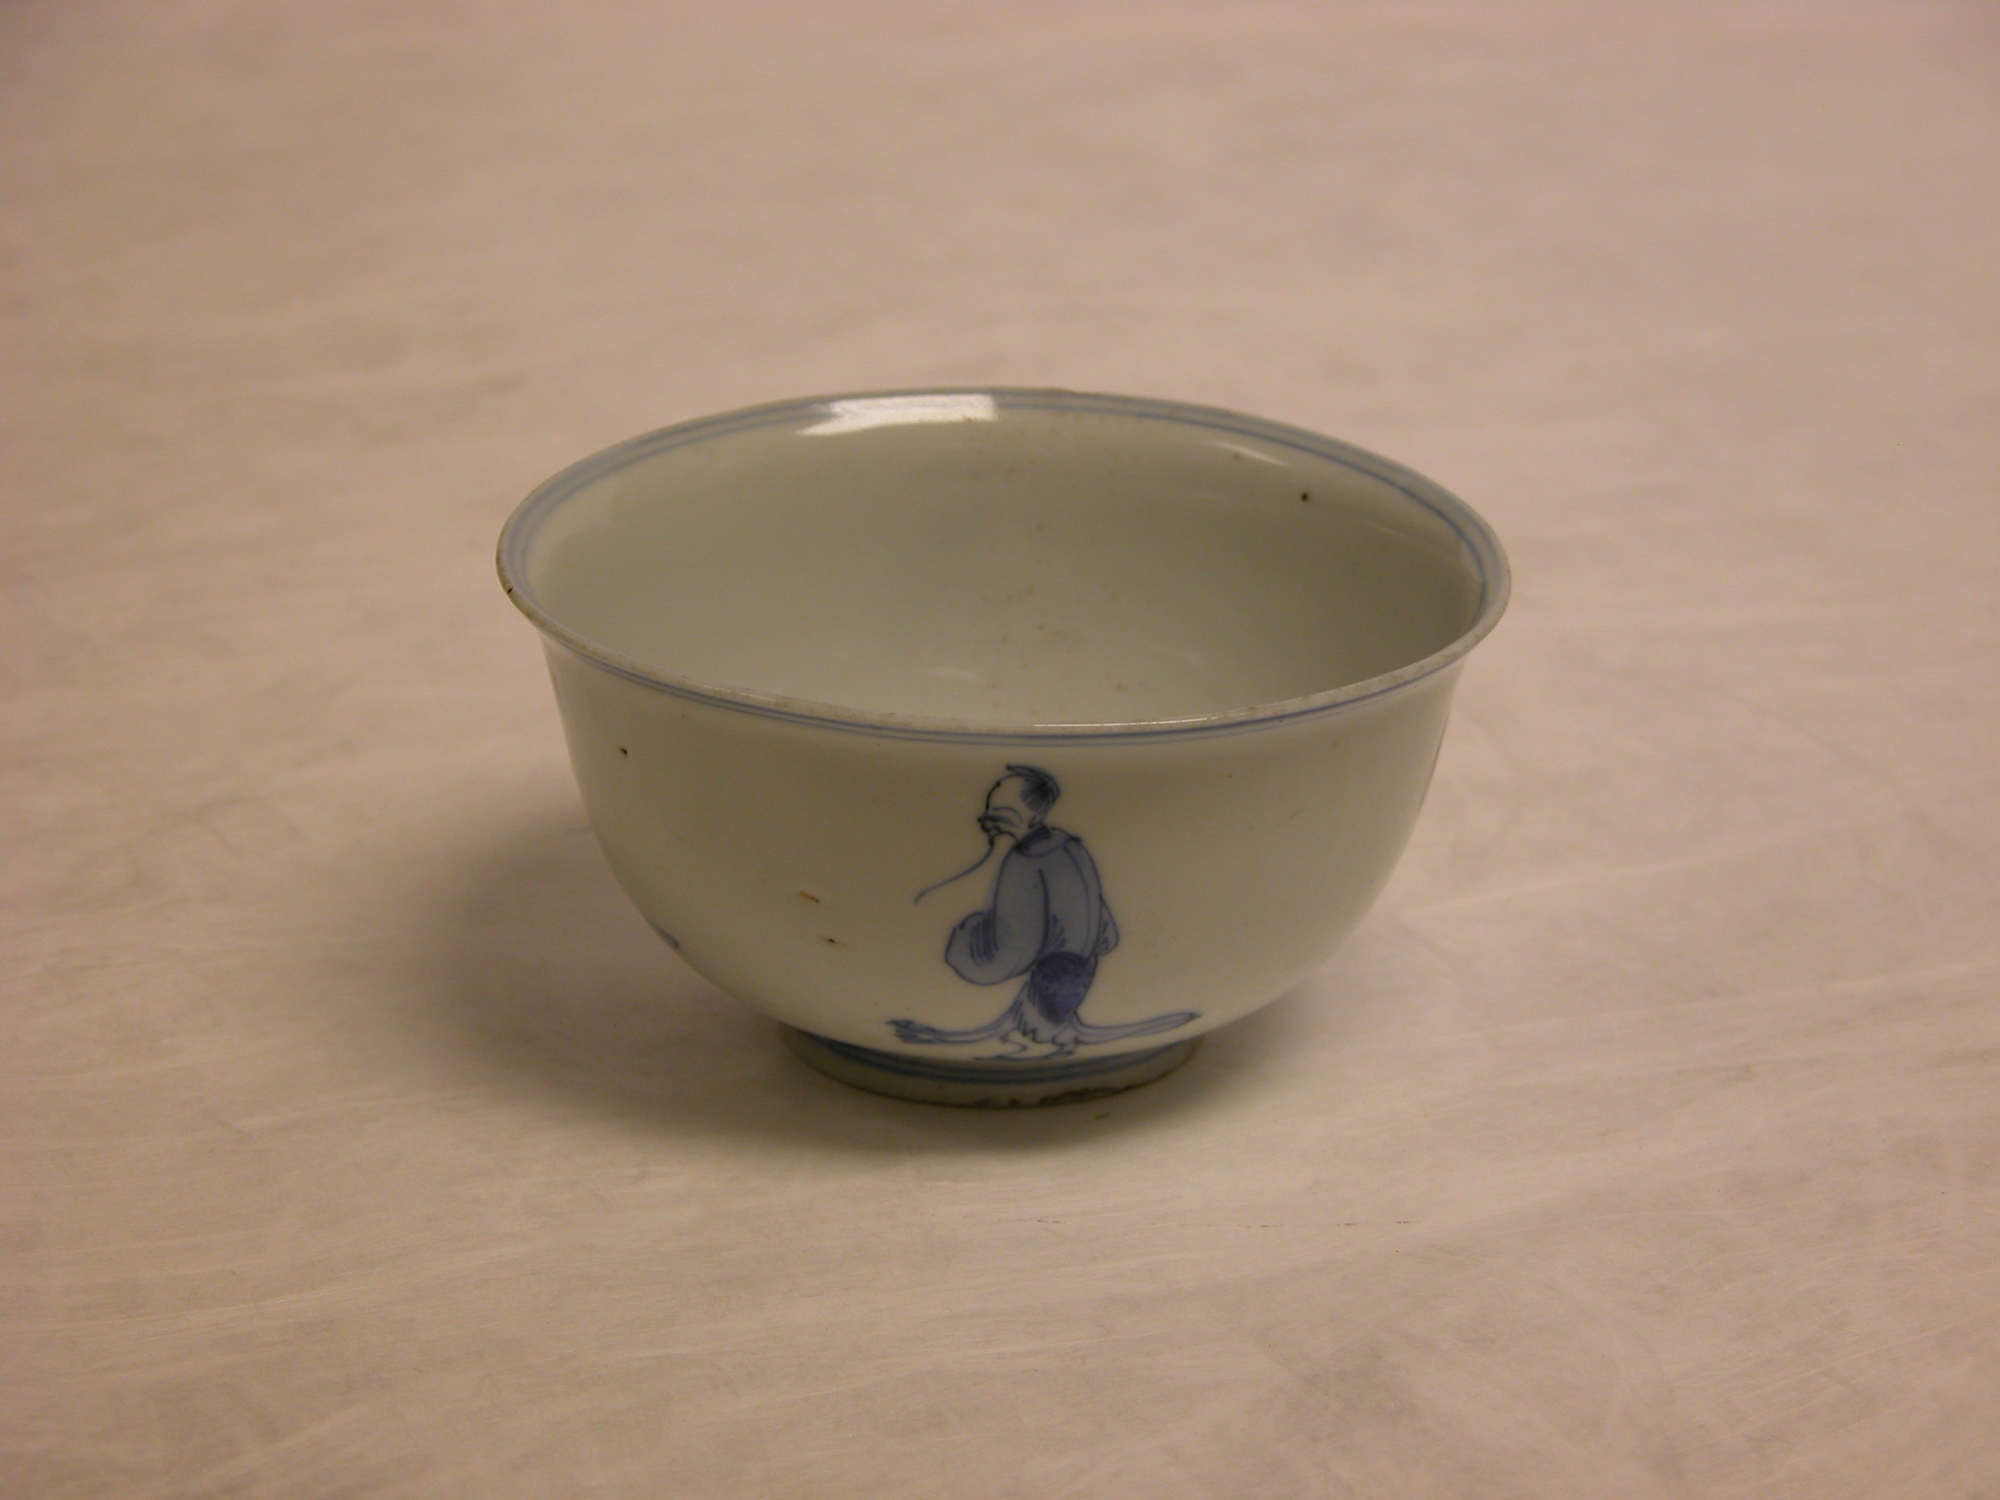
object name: cup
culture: chinese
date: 1573-1620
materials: porcelain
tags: men